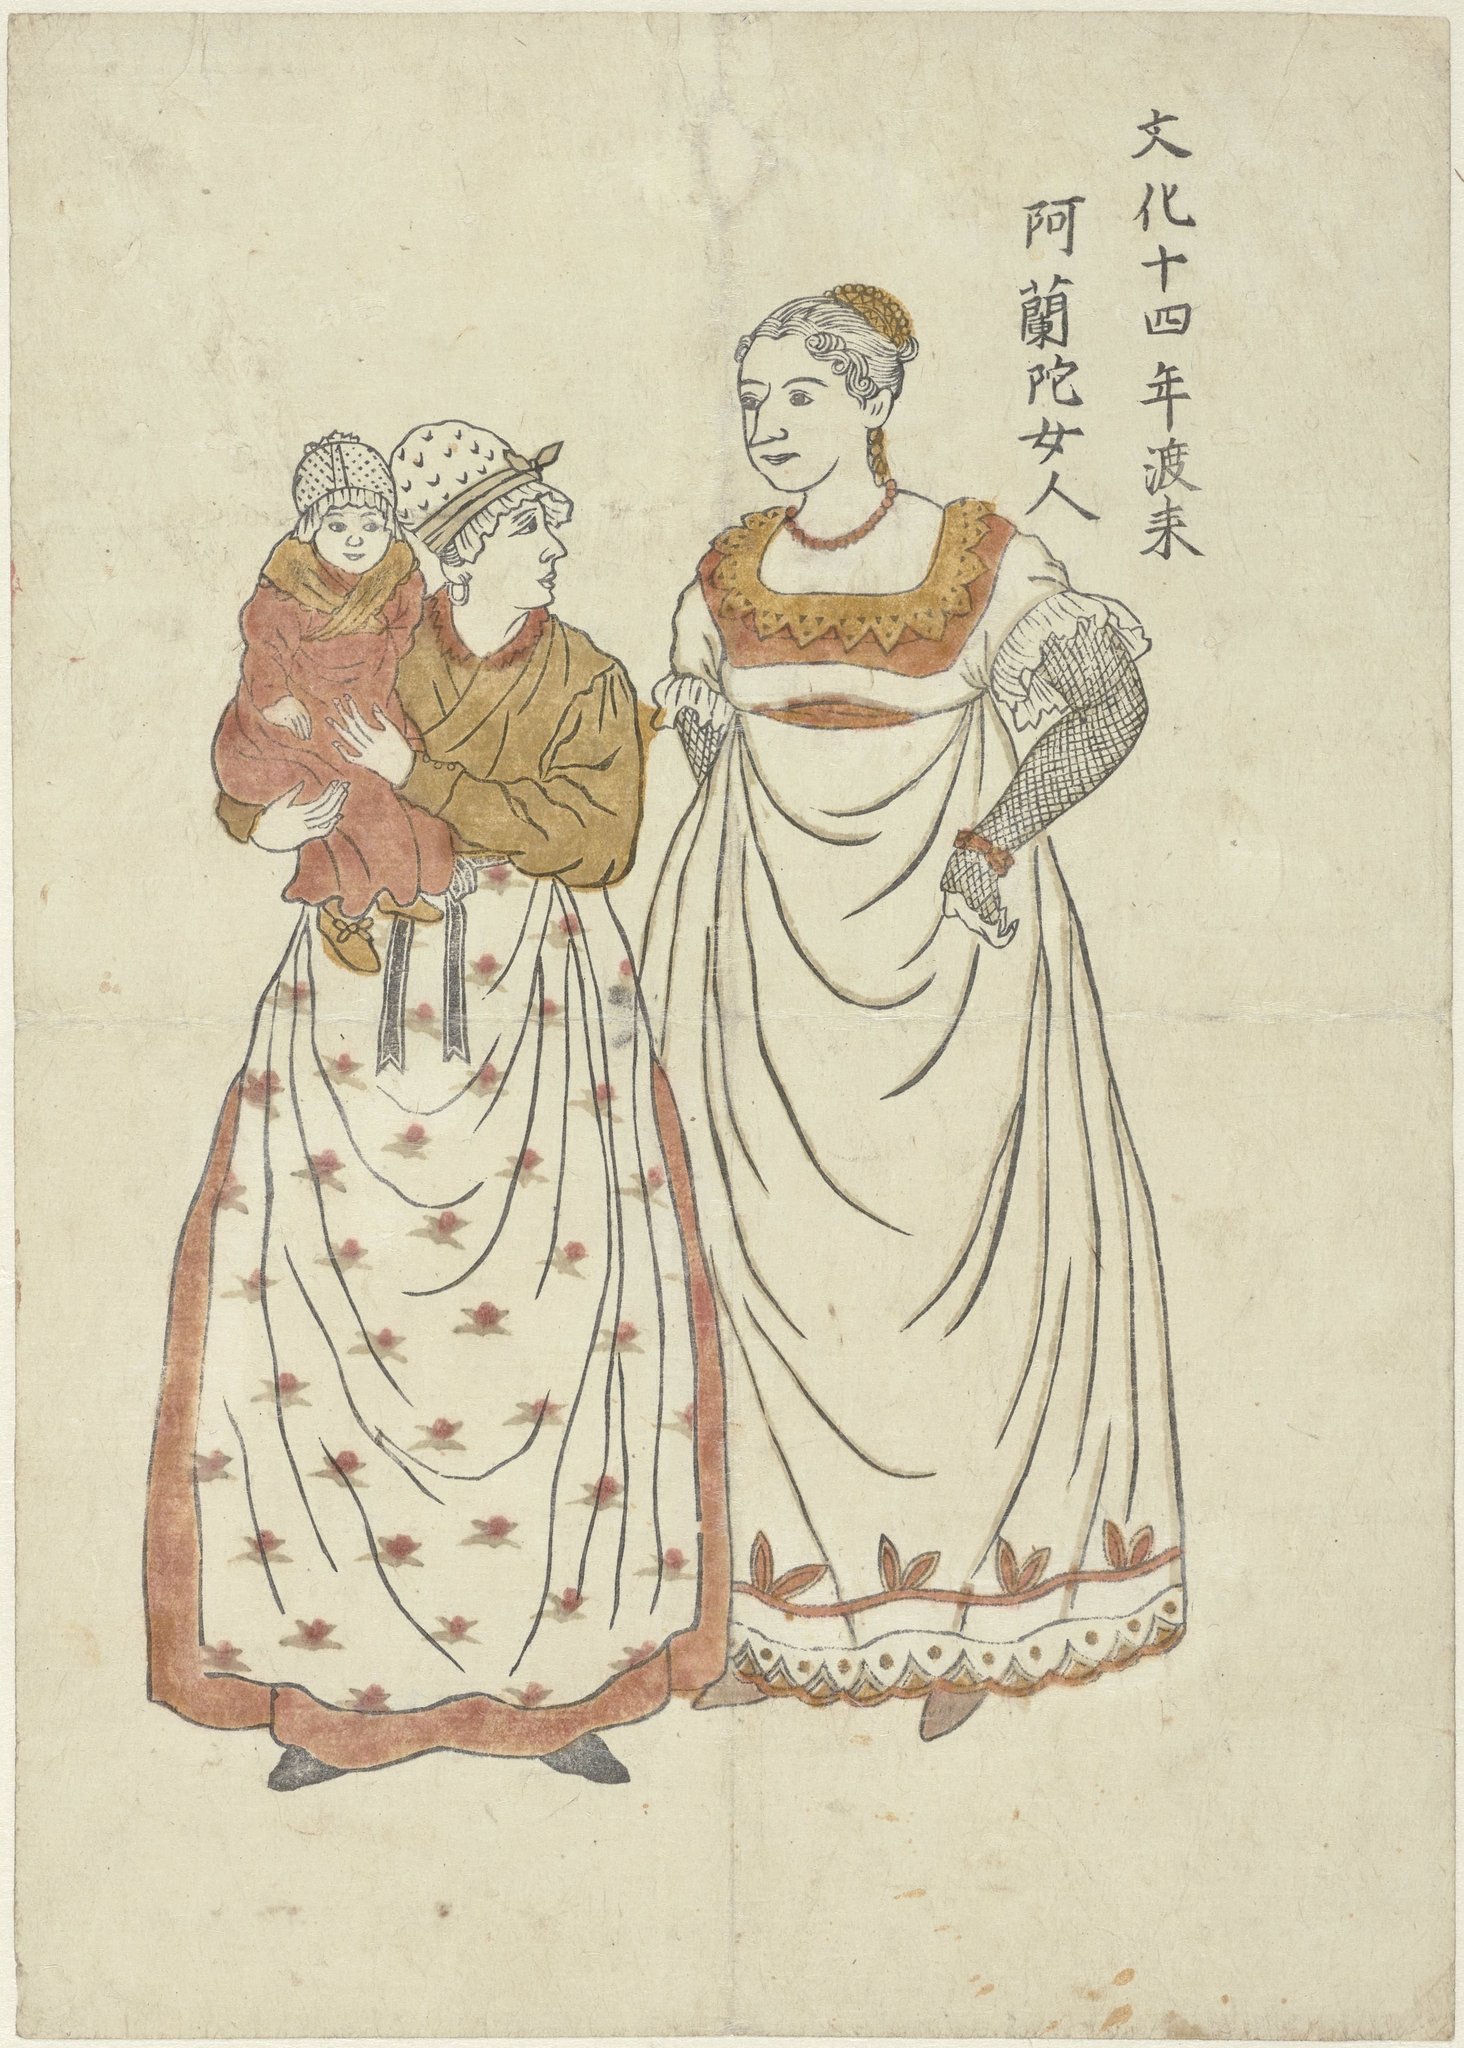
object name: print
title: Petronella with Titia and Johannes Cock Blomhoff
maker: Anonymous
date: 1817-1854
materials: paper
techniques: woodcut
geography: nagasaki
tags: mother and son(s) (family group), historical persons - bb - woman, europeans (with name)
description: Jan Cock Blomhoff, the new director of the Deshima trading colony, arrived there in 1817. Against all rules, he also brought his family with him: his wife Titia (right), their infant son Johannes, the wet nurse Petronella and the enslaved servant Maraty. They were a sight to behold, and became the subject of paintings that served as examples for prints long afterwards. Unfortunately, the women and child had to pack up and return to Batavia (now Jakarta).